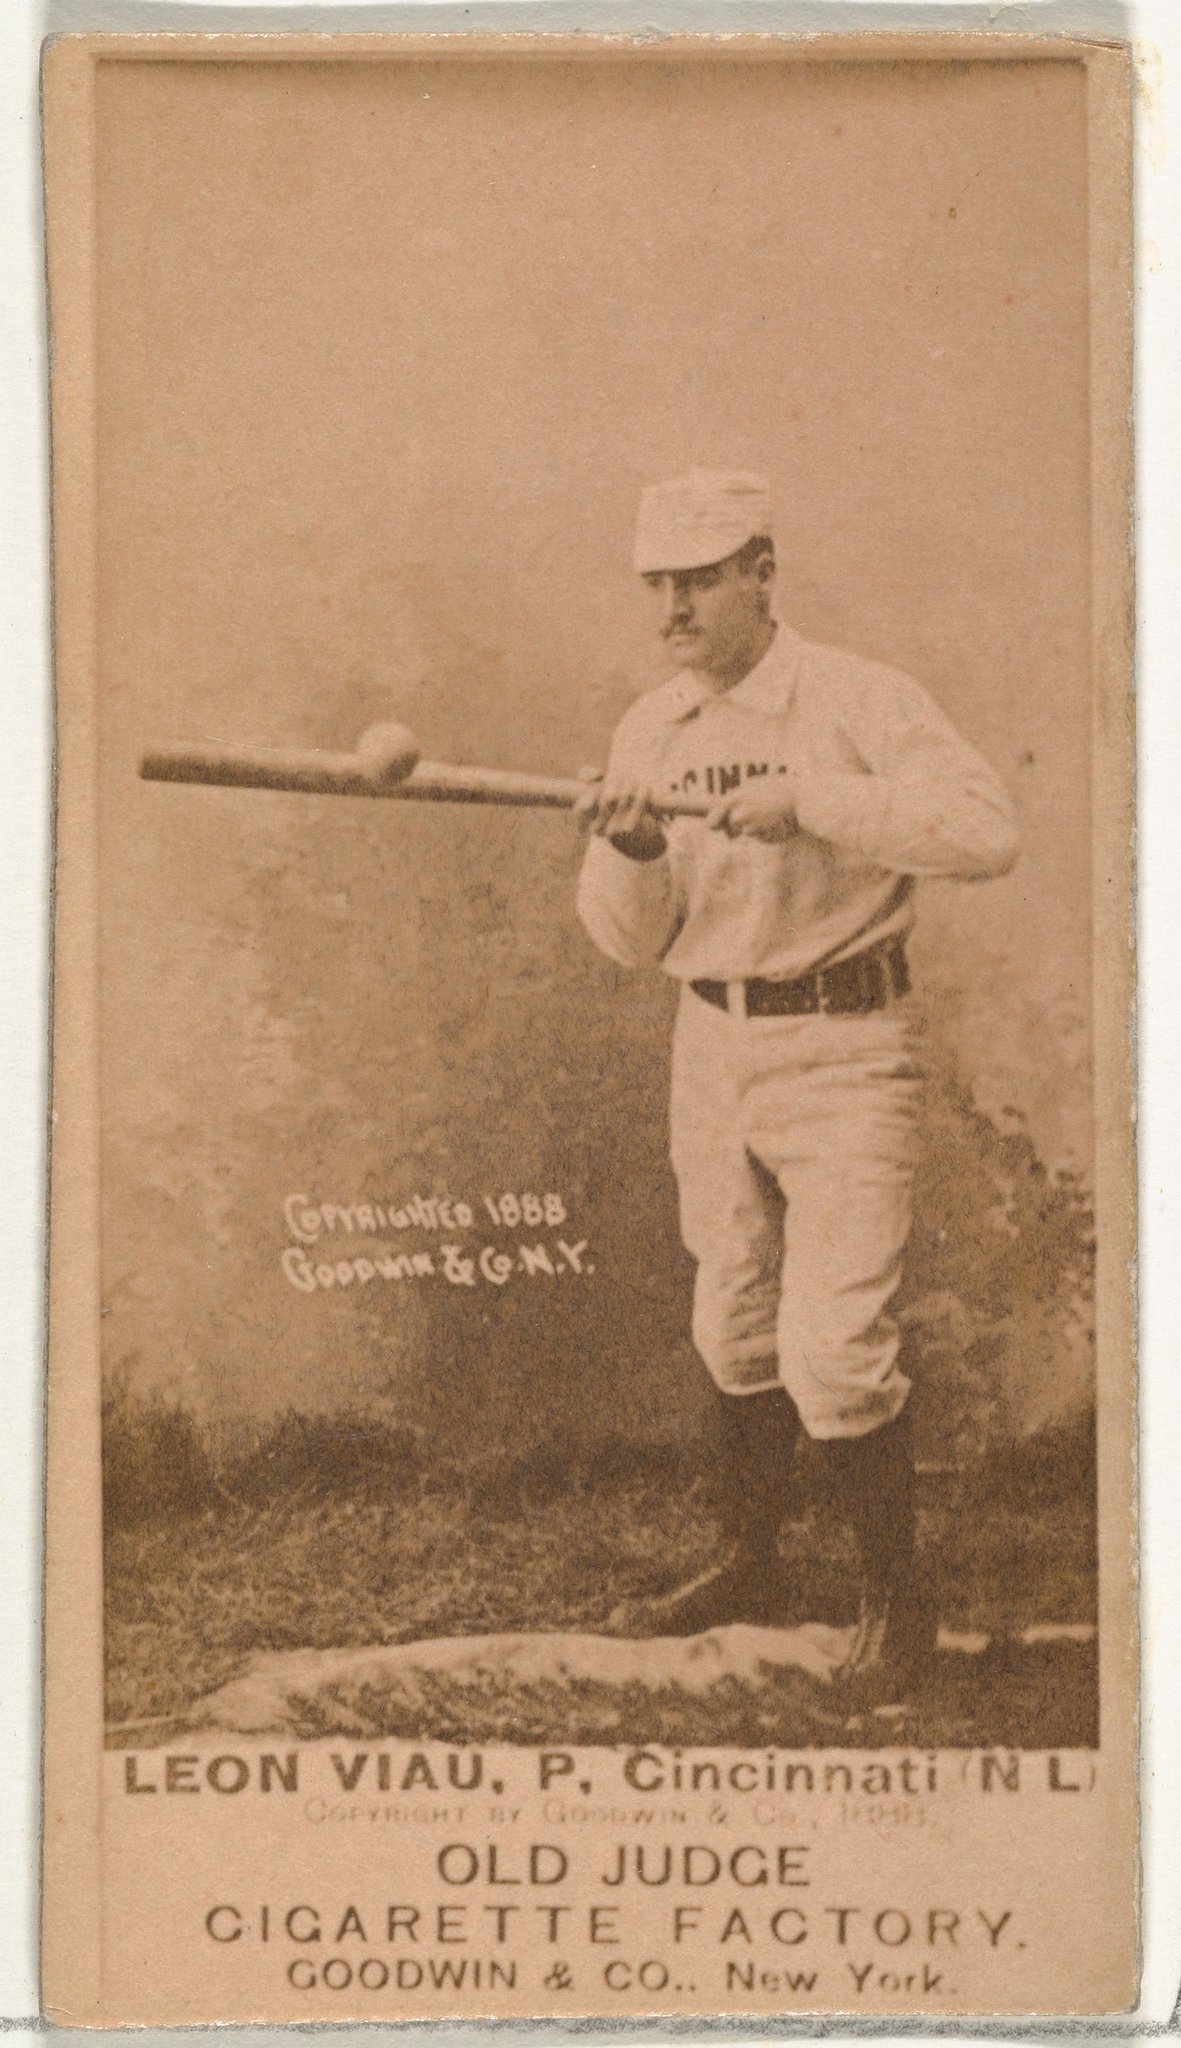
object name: baseball card, photograph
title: Leon A. "Lee" Viau, Pitcher, Cincinnati, from the Old Judge series (N172) for Old Judge Cigarettes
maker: goodwin & company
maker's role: publisher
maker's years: 1850-1950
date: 1888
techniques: albumen silver print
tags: men,portraits,baseball,athletes